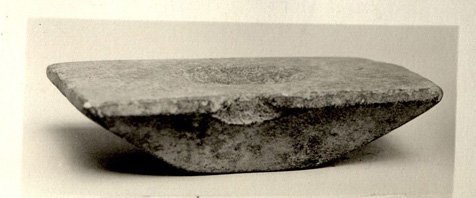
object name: grinding slab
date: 1981-1640 BCE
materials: stone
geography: egypt